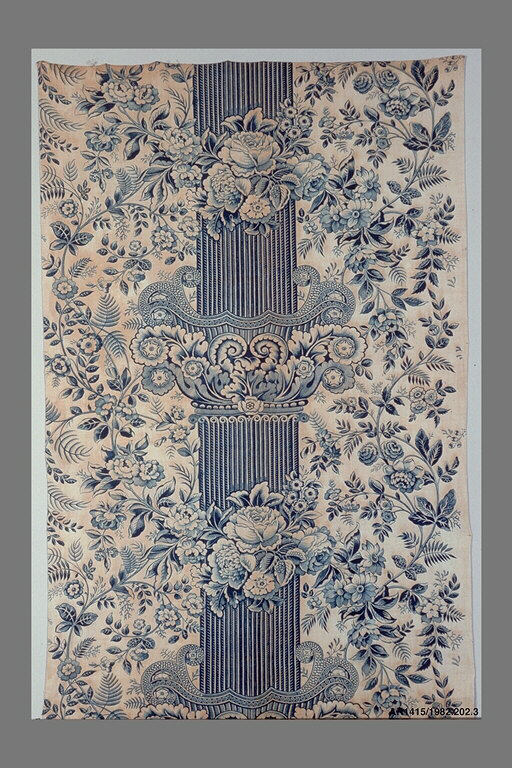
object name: length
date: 1830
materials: cotton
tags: flowers